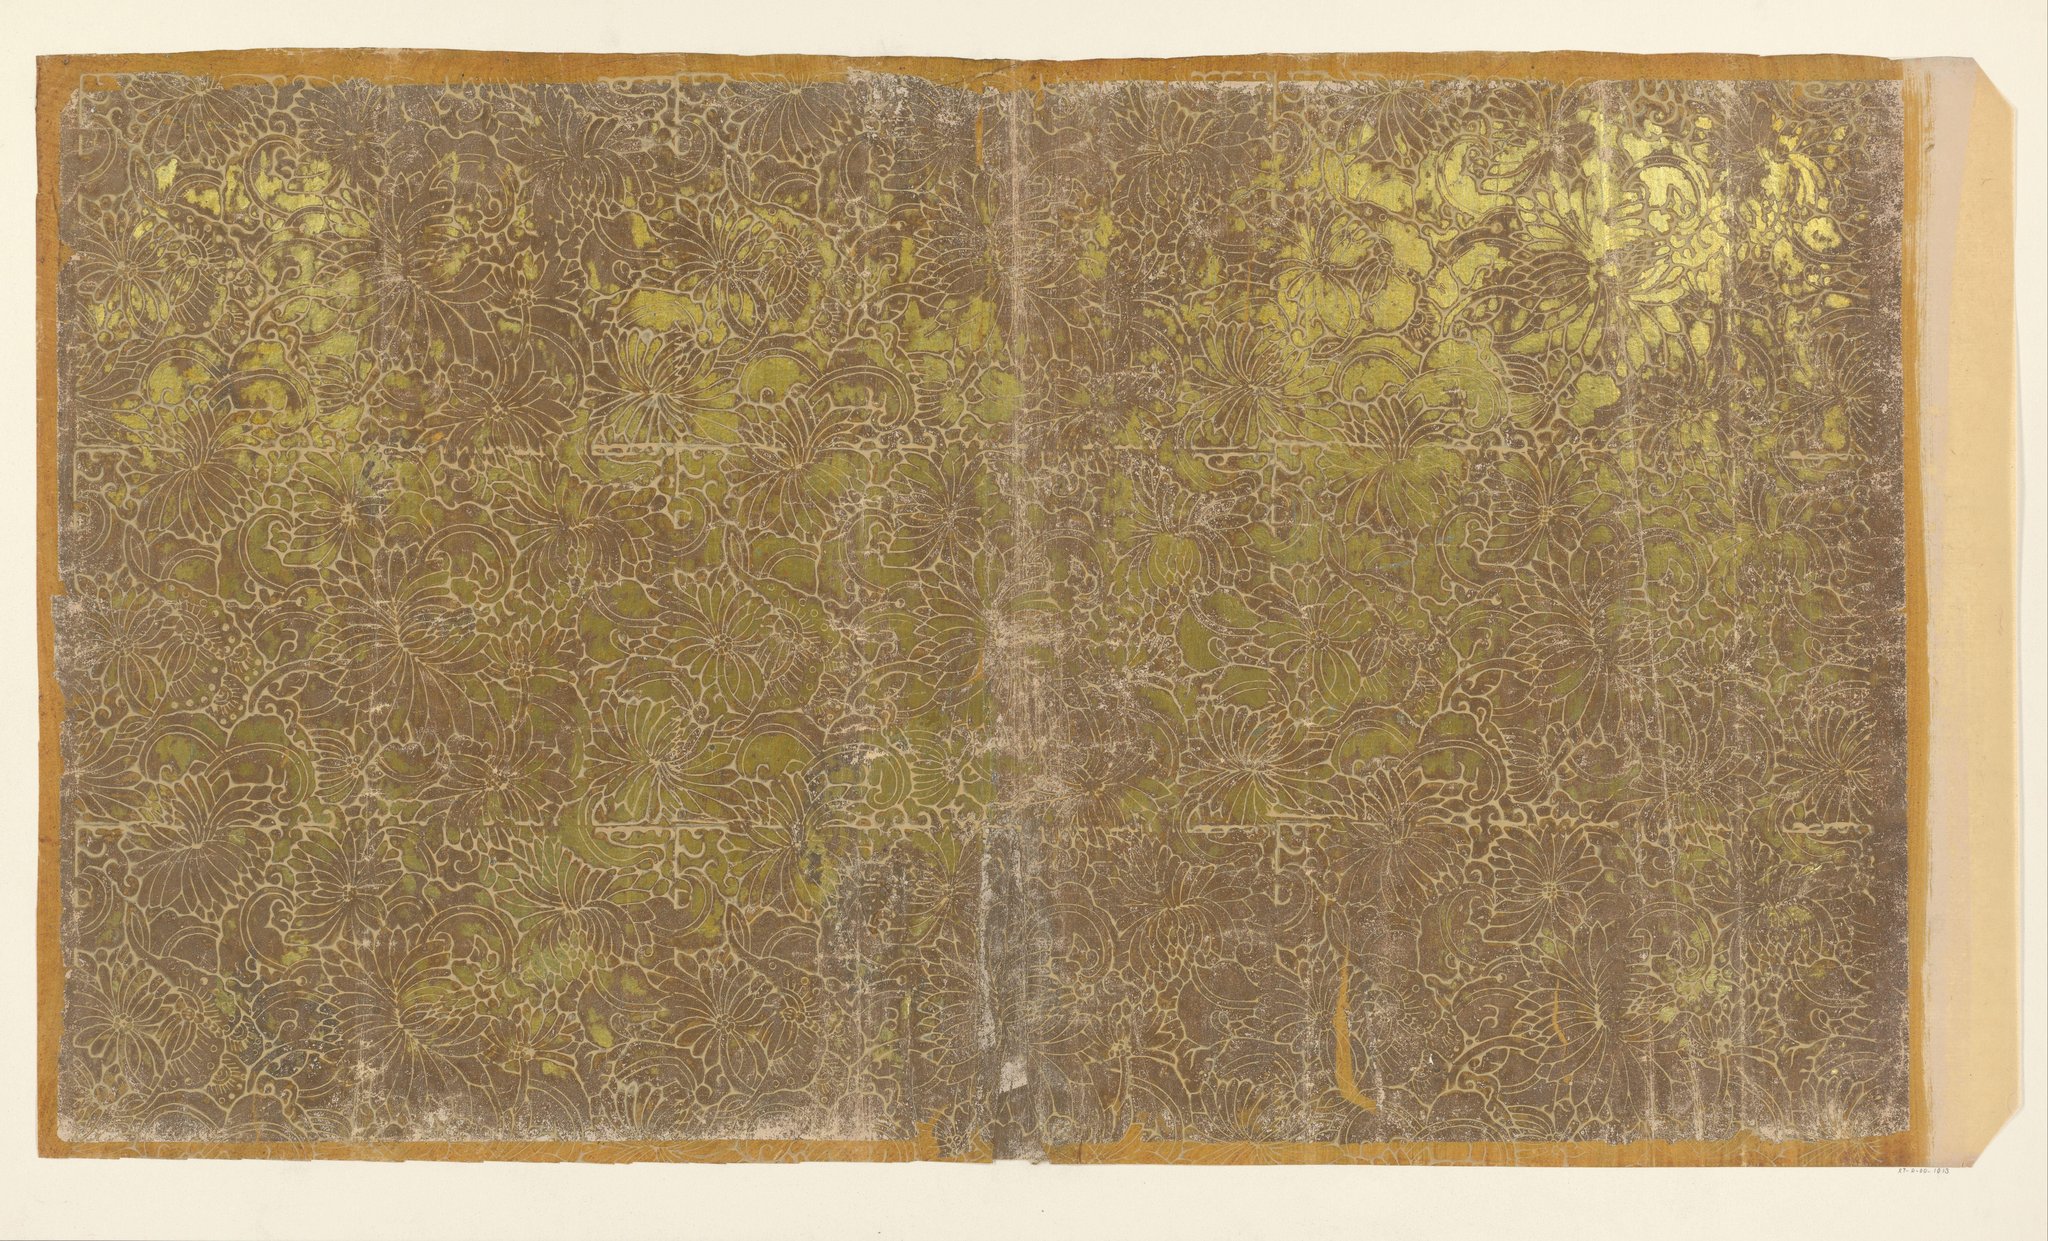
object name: decorated paper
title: Blad met aaneengesloten bladvullend patroon van chrysanten (één van tien identieke bladen)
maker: Anonymous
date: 1850-1950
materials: paper, gold leaf, paint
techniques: printing block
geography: japan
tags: flowers: chrysanthemum, ornament derived from plant forms